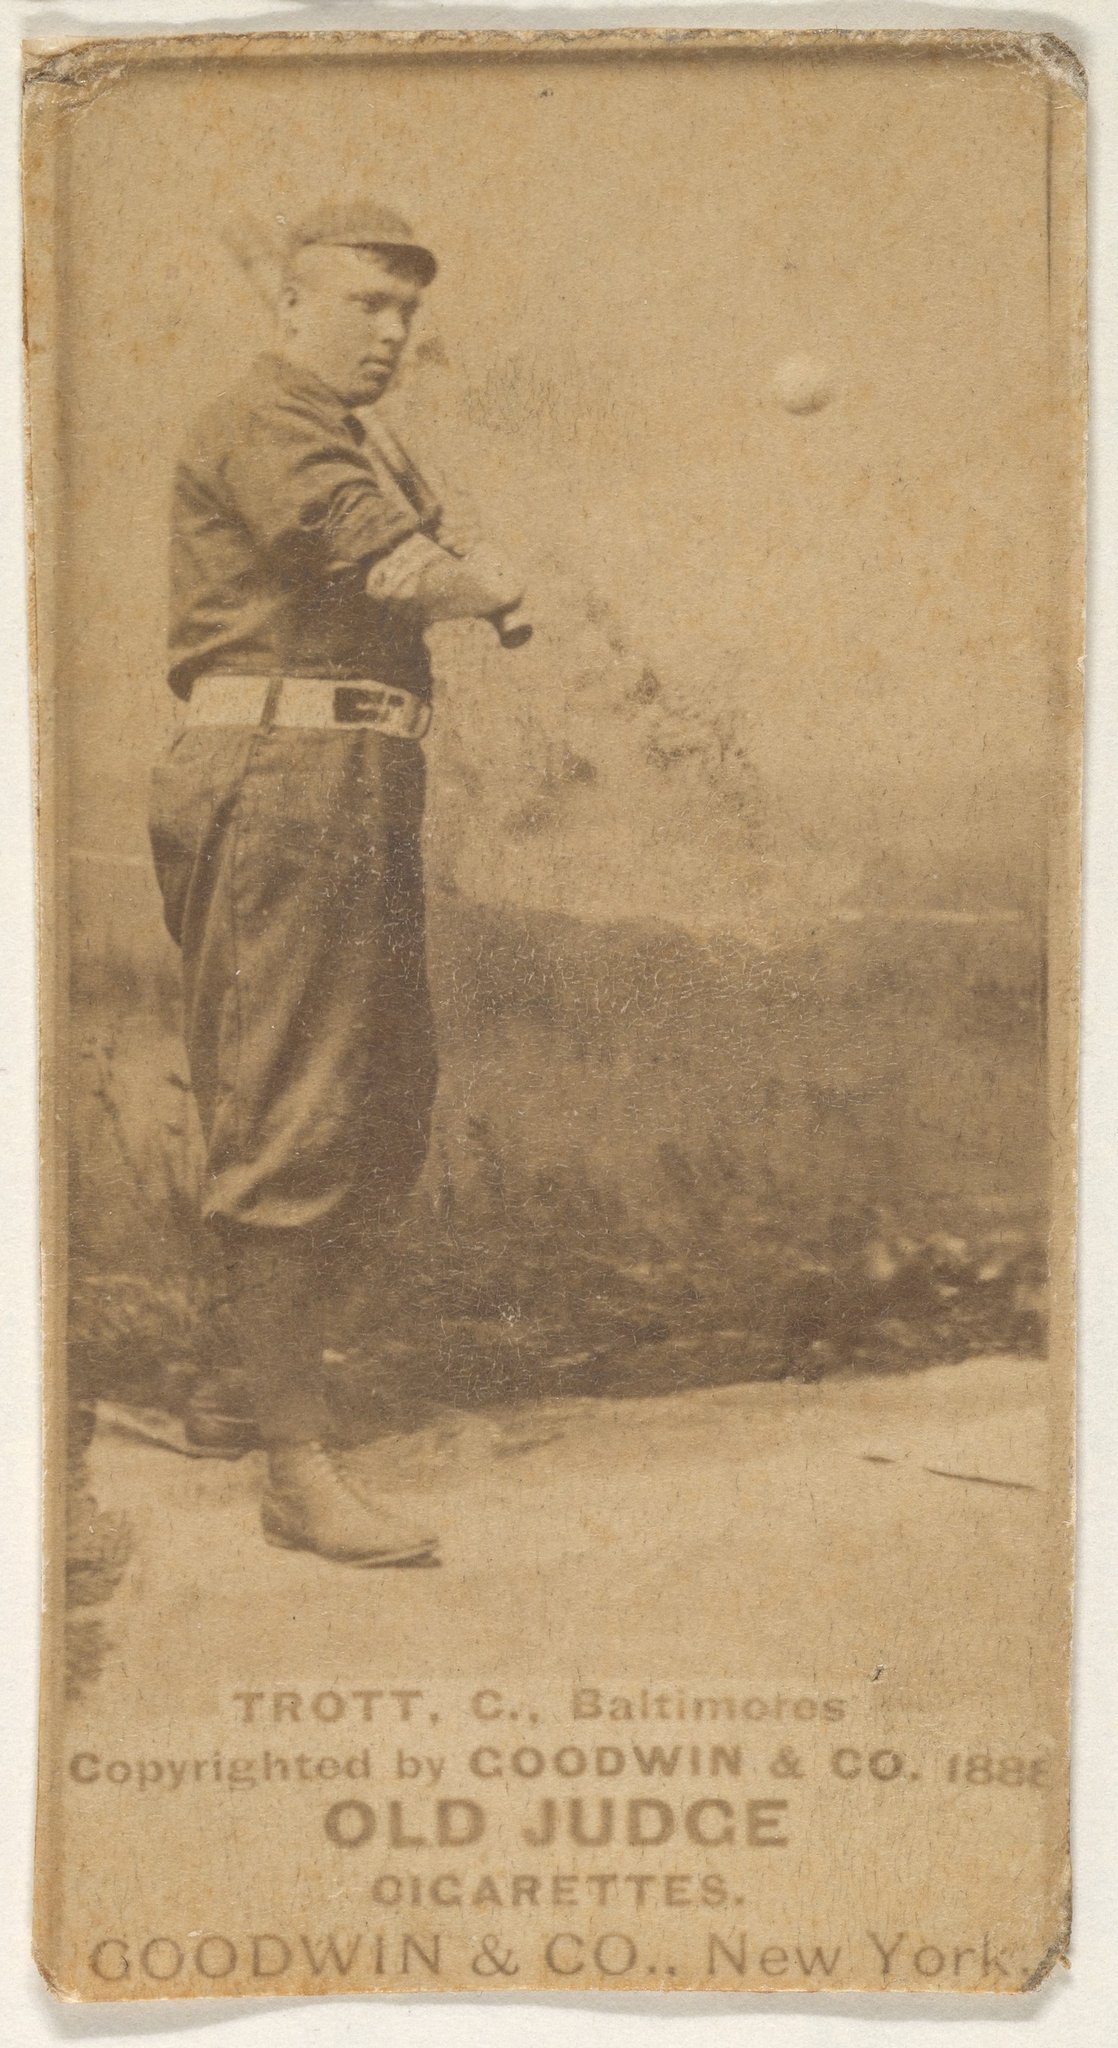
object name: baseball card, photograph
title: Trott, Catcher, Baltimore Orioles, from the Old Judge series (N172) for Old Judge Cigarettes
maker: goodwin & company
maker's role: publisher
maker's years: 1850-1950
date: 1888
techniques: albumen silver print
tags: men,portraits,baseball,athletes